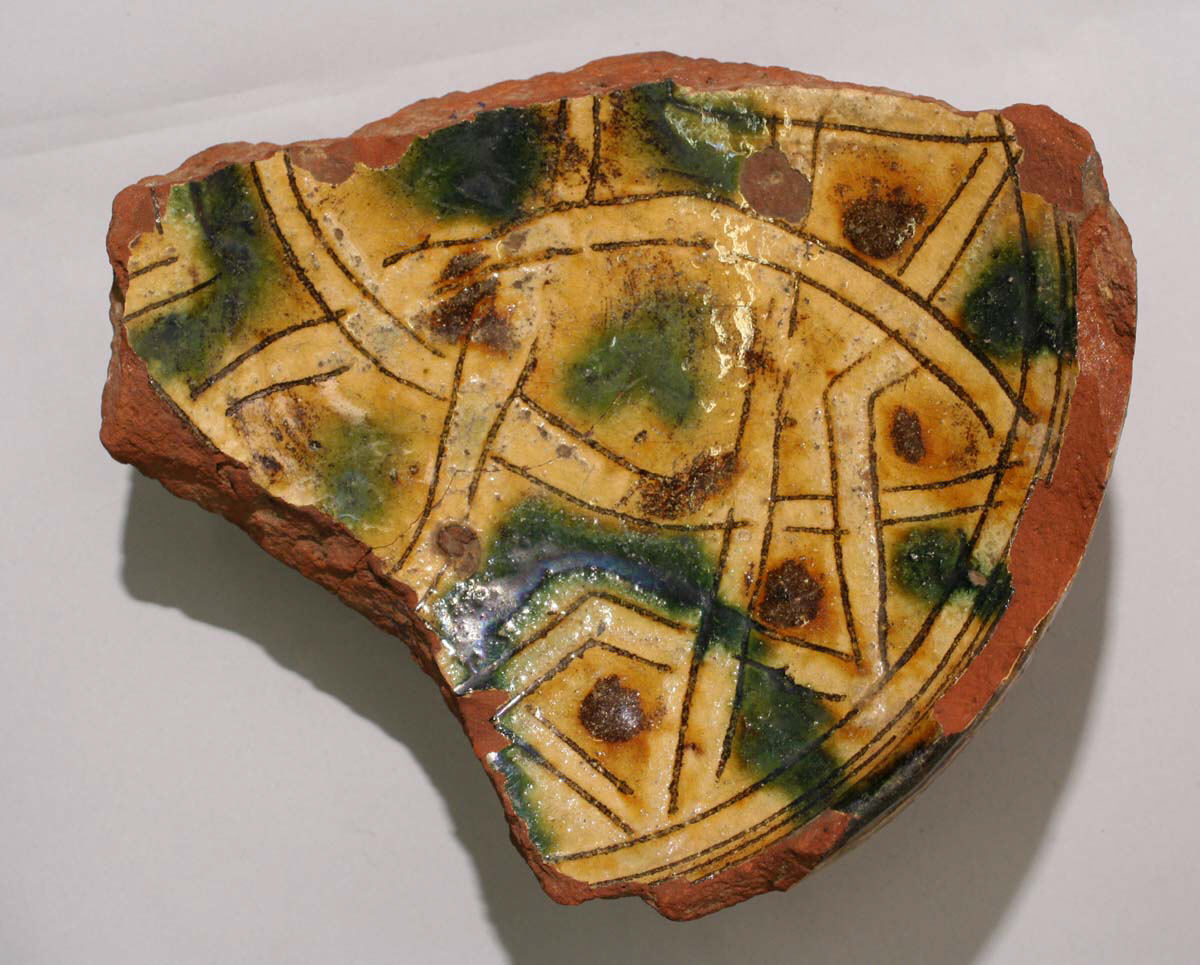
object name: fragment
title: Fragment of a Plate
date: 1301-1500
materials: earthenware, glaze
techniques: coloring, incising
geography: egypt